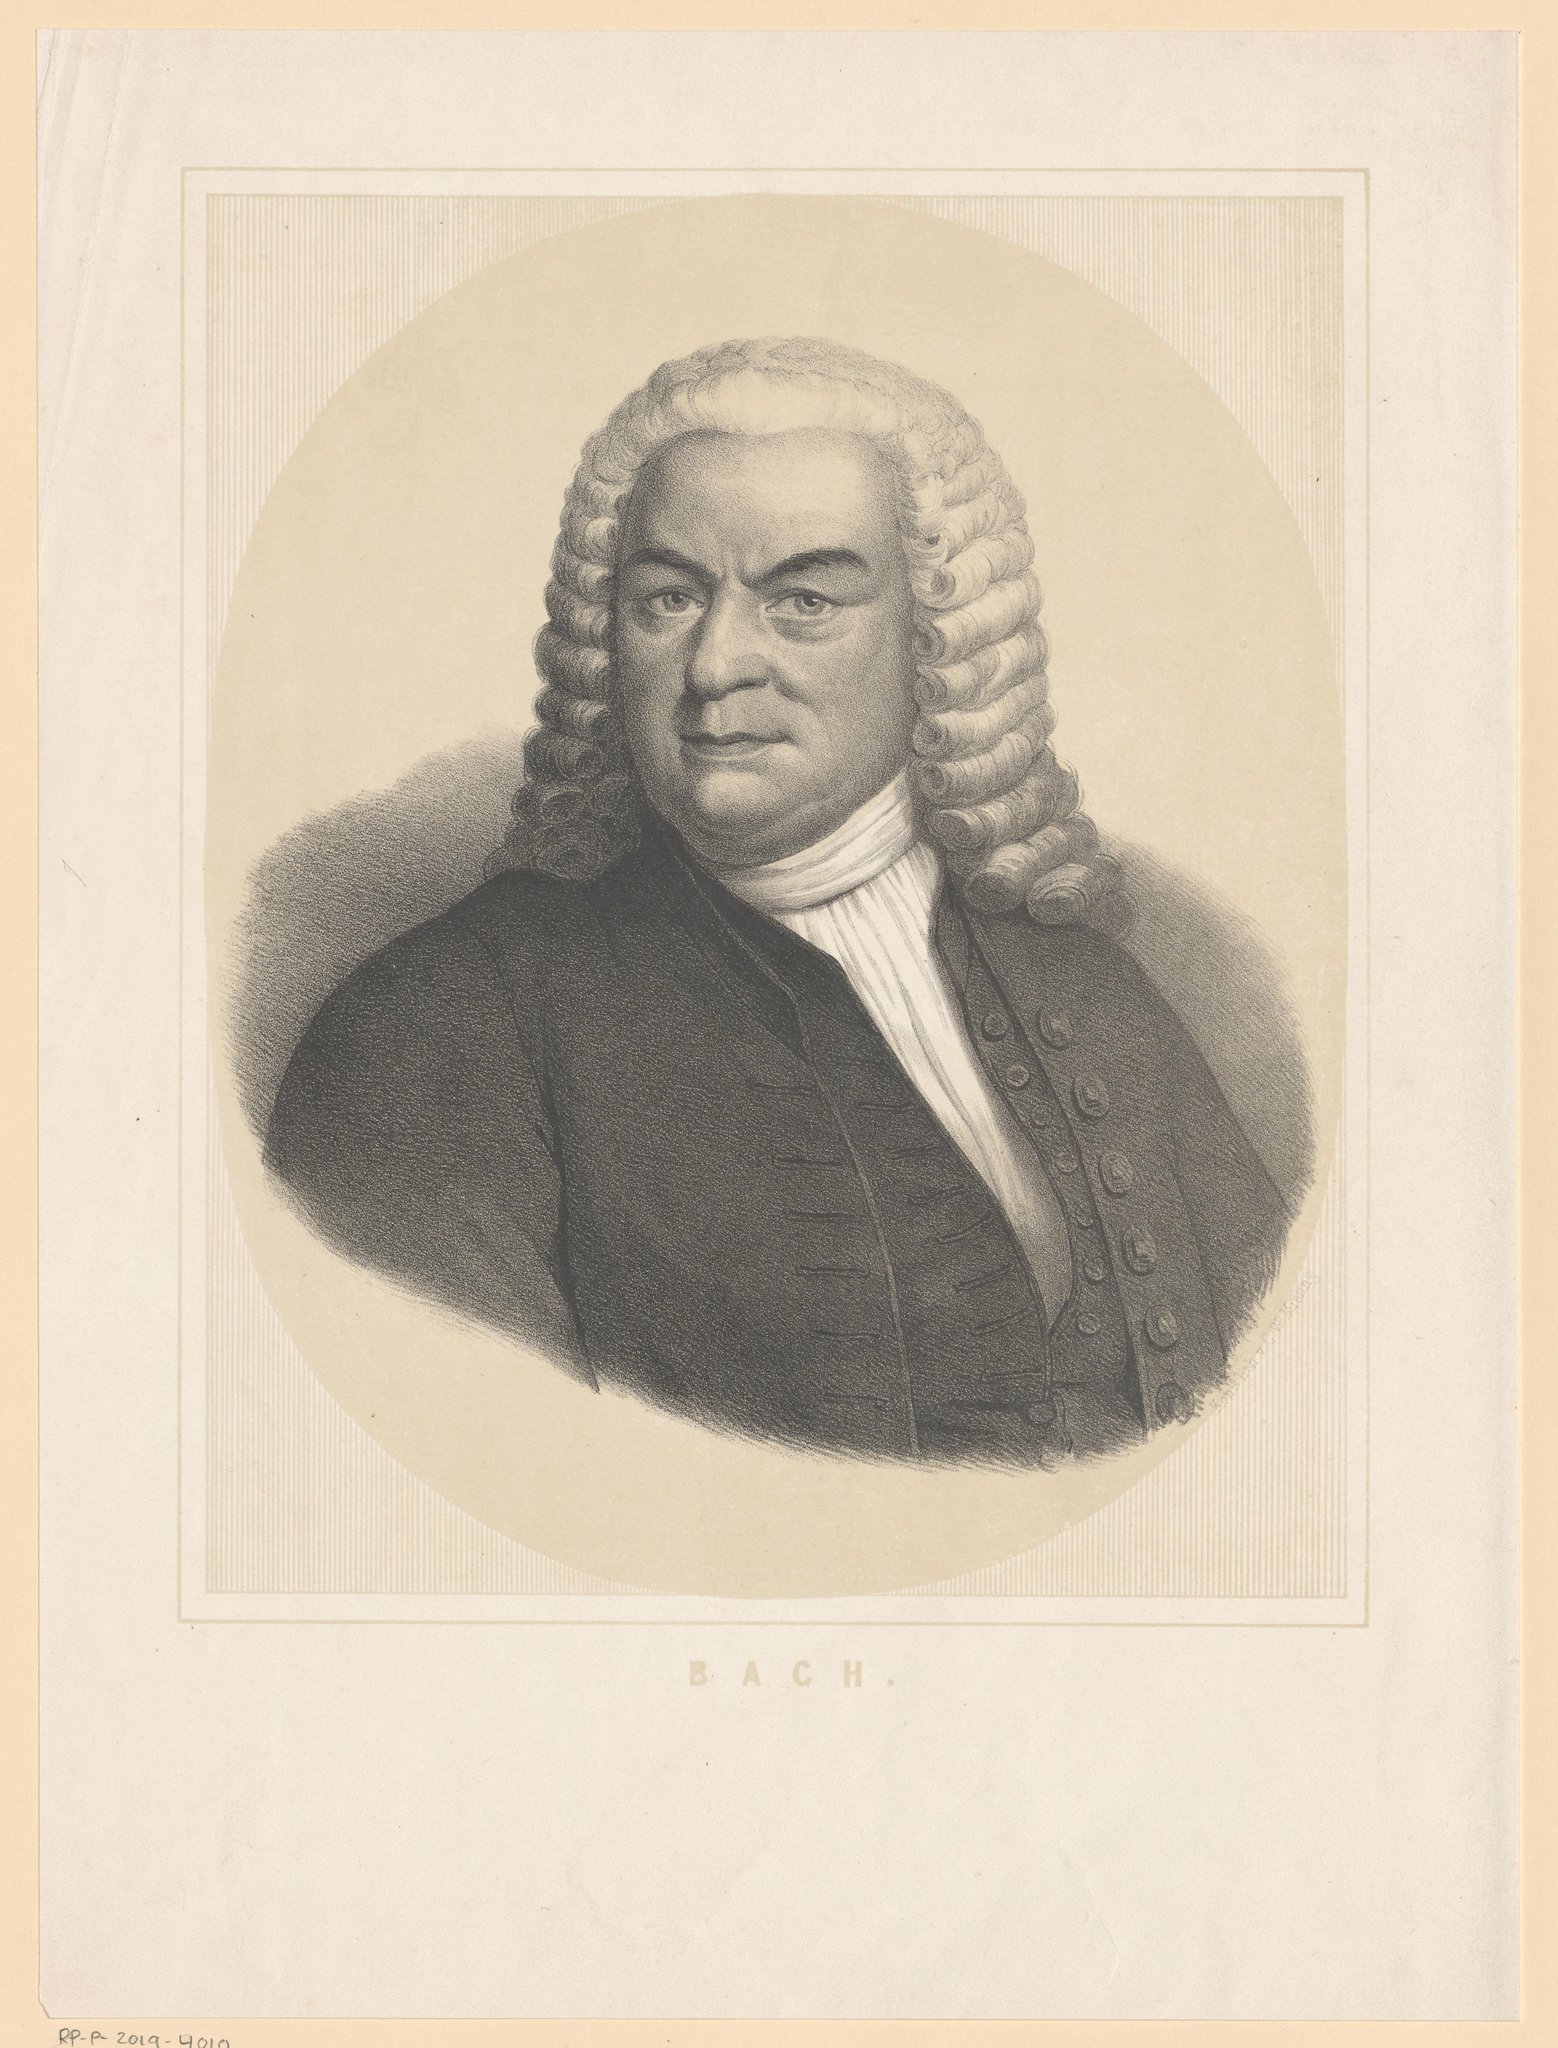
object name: print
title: Portret van Johann Sebastian Bach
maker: Anonymous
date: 1839-1865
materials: paper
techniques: tone lithography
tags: historical persons